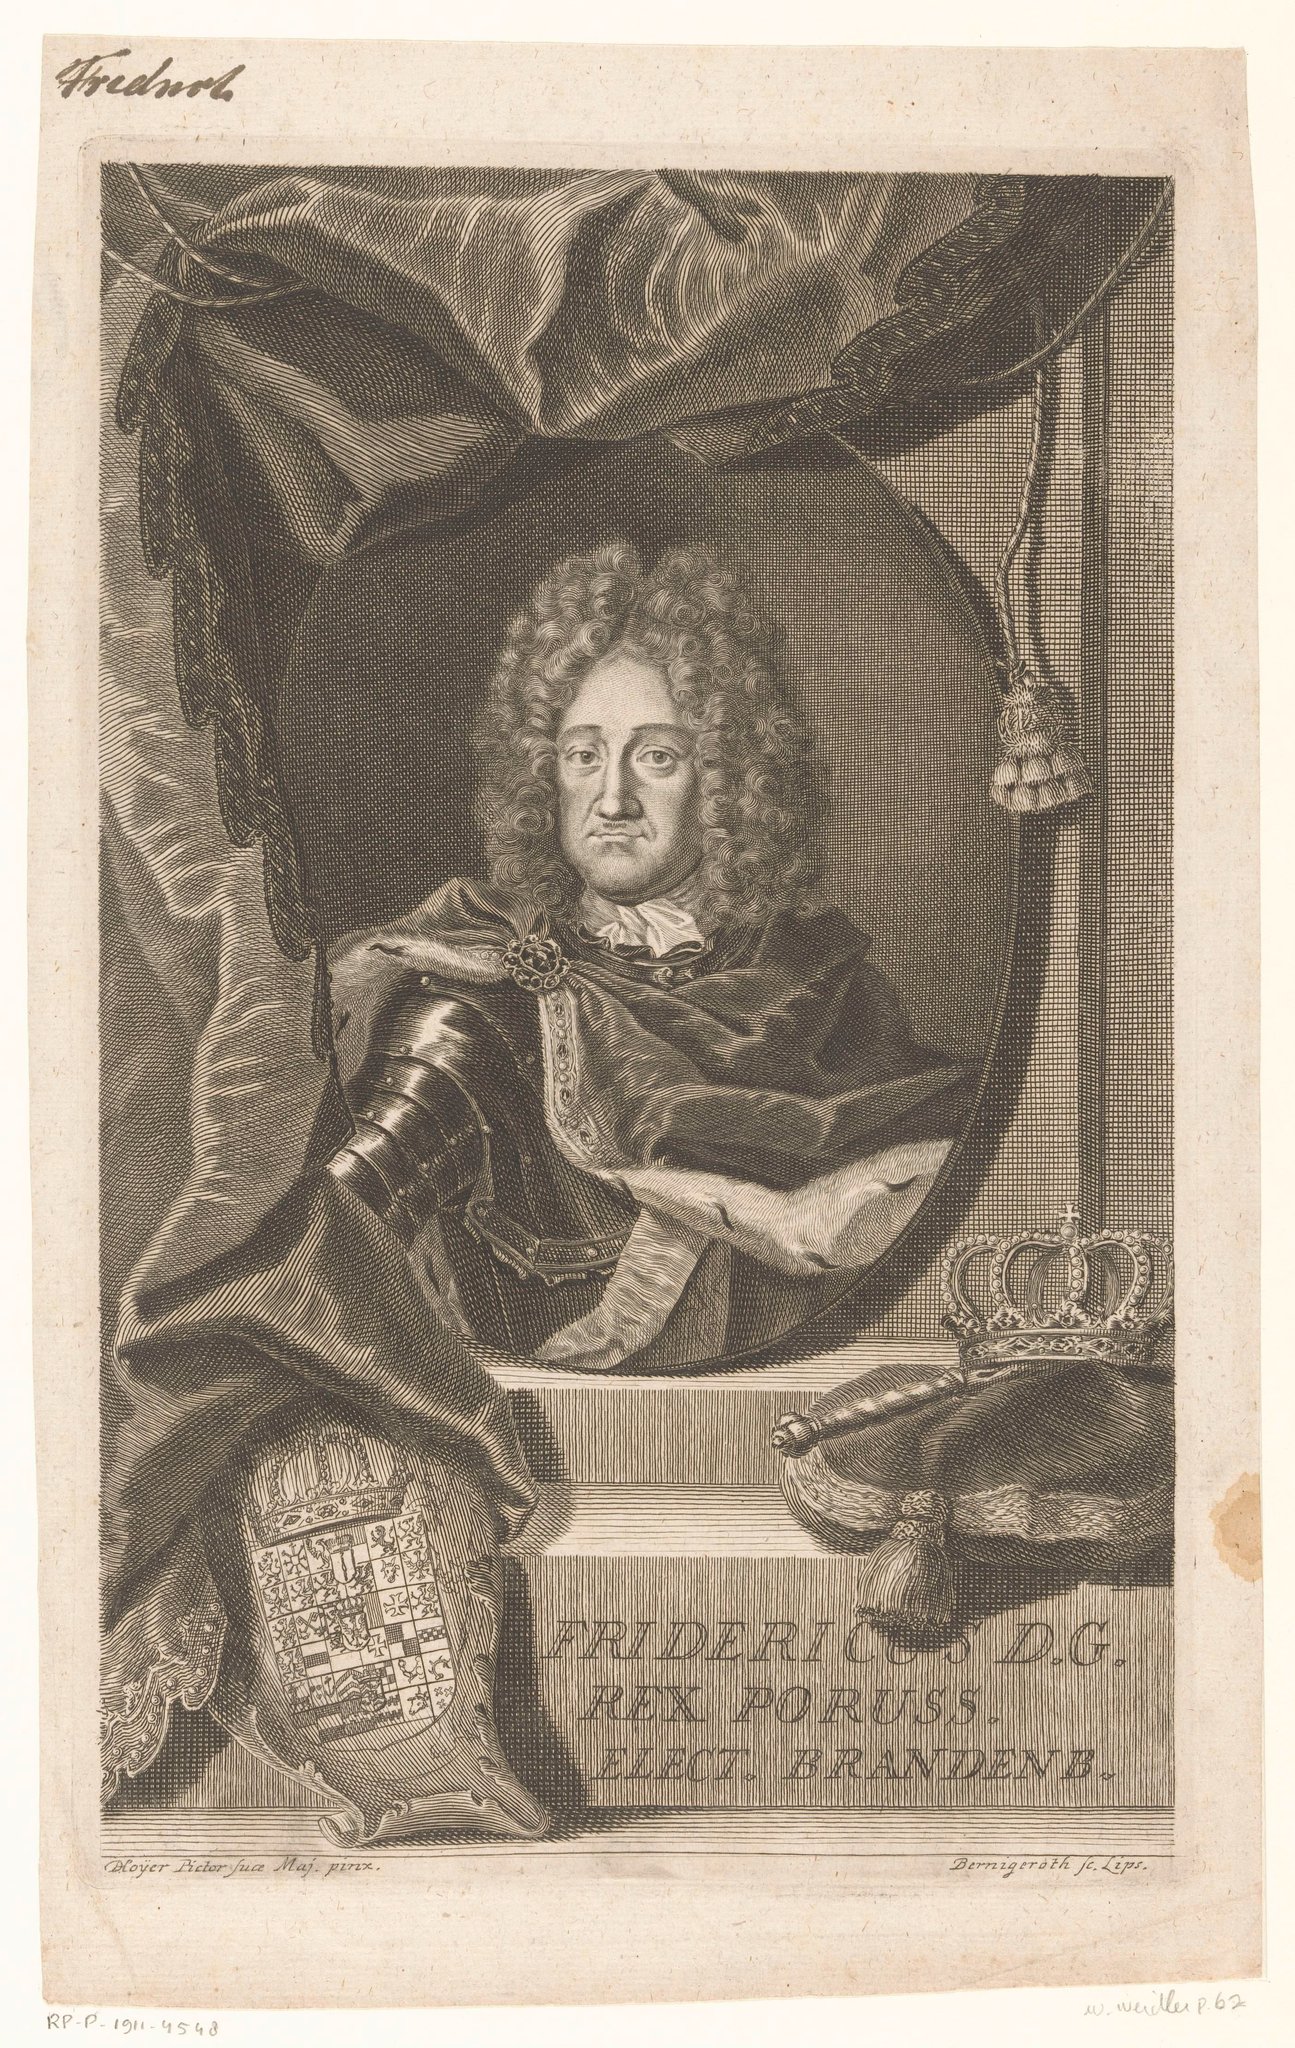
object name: print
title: Portret van Friedrich I, koning van Pruisen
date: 1701-1713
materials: paper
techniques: engraving, etching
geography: leipzig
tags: berlin, frederik i koning van pruisen, armour, historical persons, armorial bearing, heraldry, insignia and symbols of sovereignty (crown, diadem, sceptre, orb, seal, standard, cloak, pectoral)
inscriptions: collector's mark: Lugt 2228